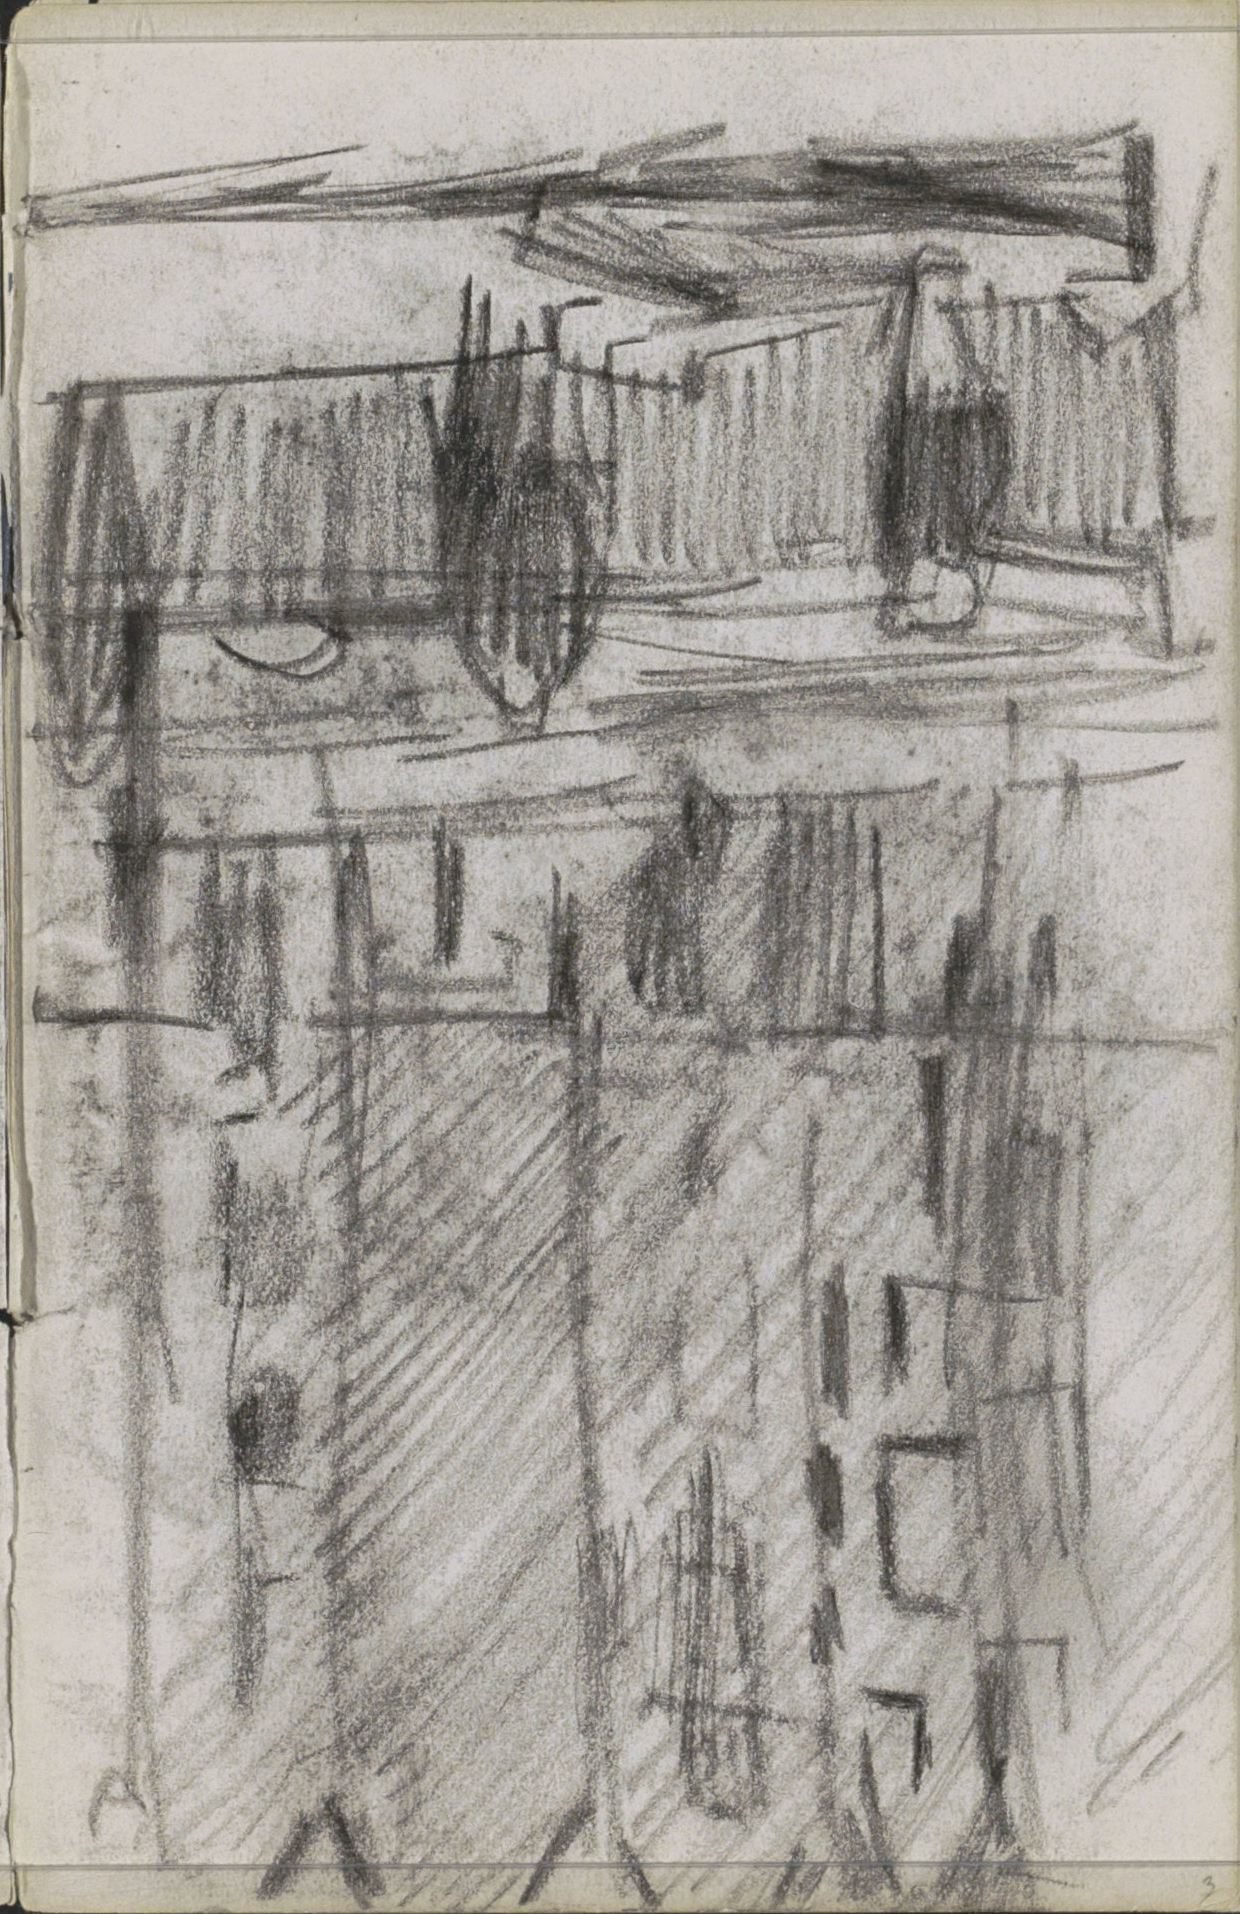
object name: sketchbook leaf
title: Figuren aan een gracht, mogelijk in Amsterdam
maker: isaac israels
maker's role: draughtsman, painter, print maker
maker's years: 1865-1934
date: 1875-1934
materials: chalk, paper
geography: amsterdam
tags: canals, waters (in city) (+ city(-scape) with figures, staffage), amsterdam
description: Pagina 3 uit schetsboek XXIX met 44 pagina's.